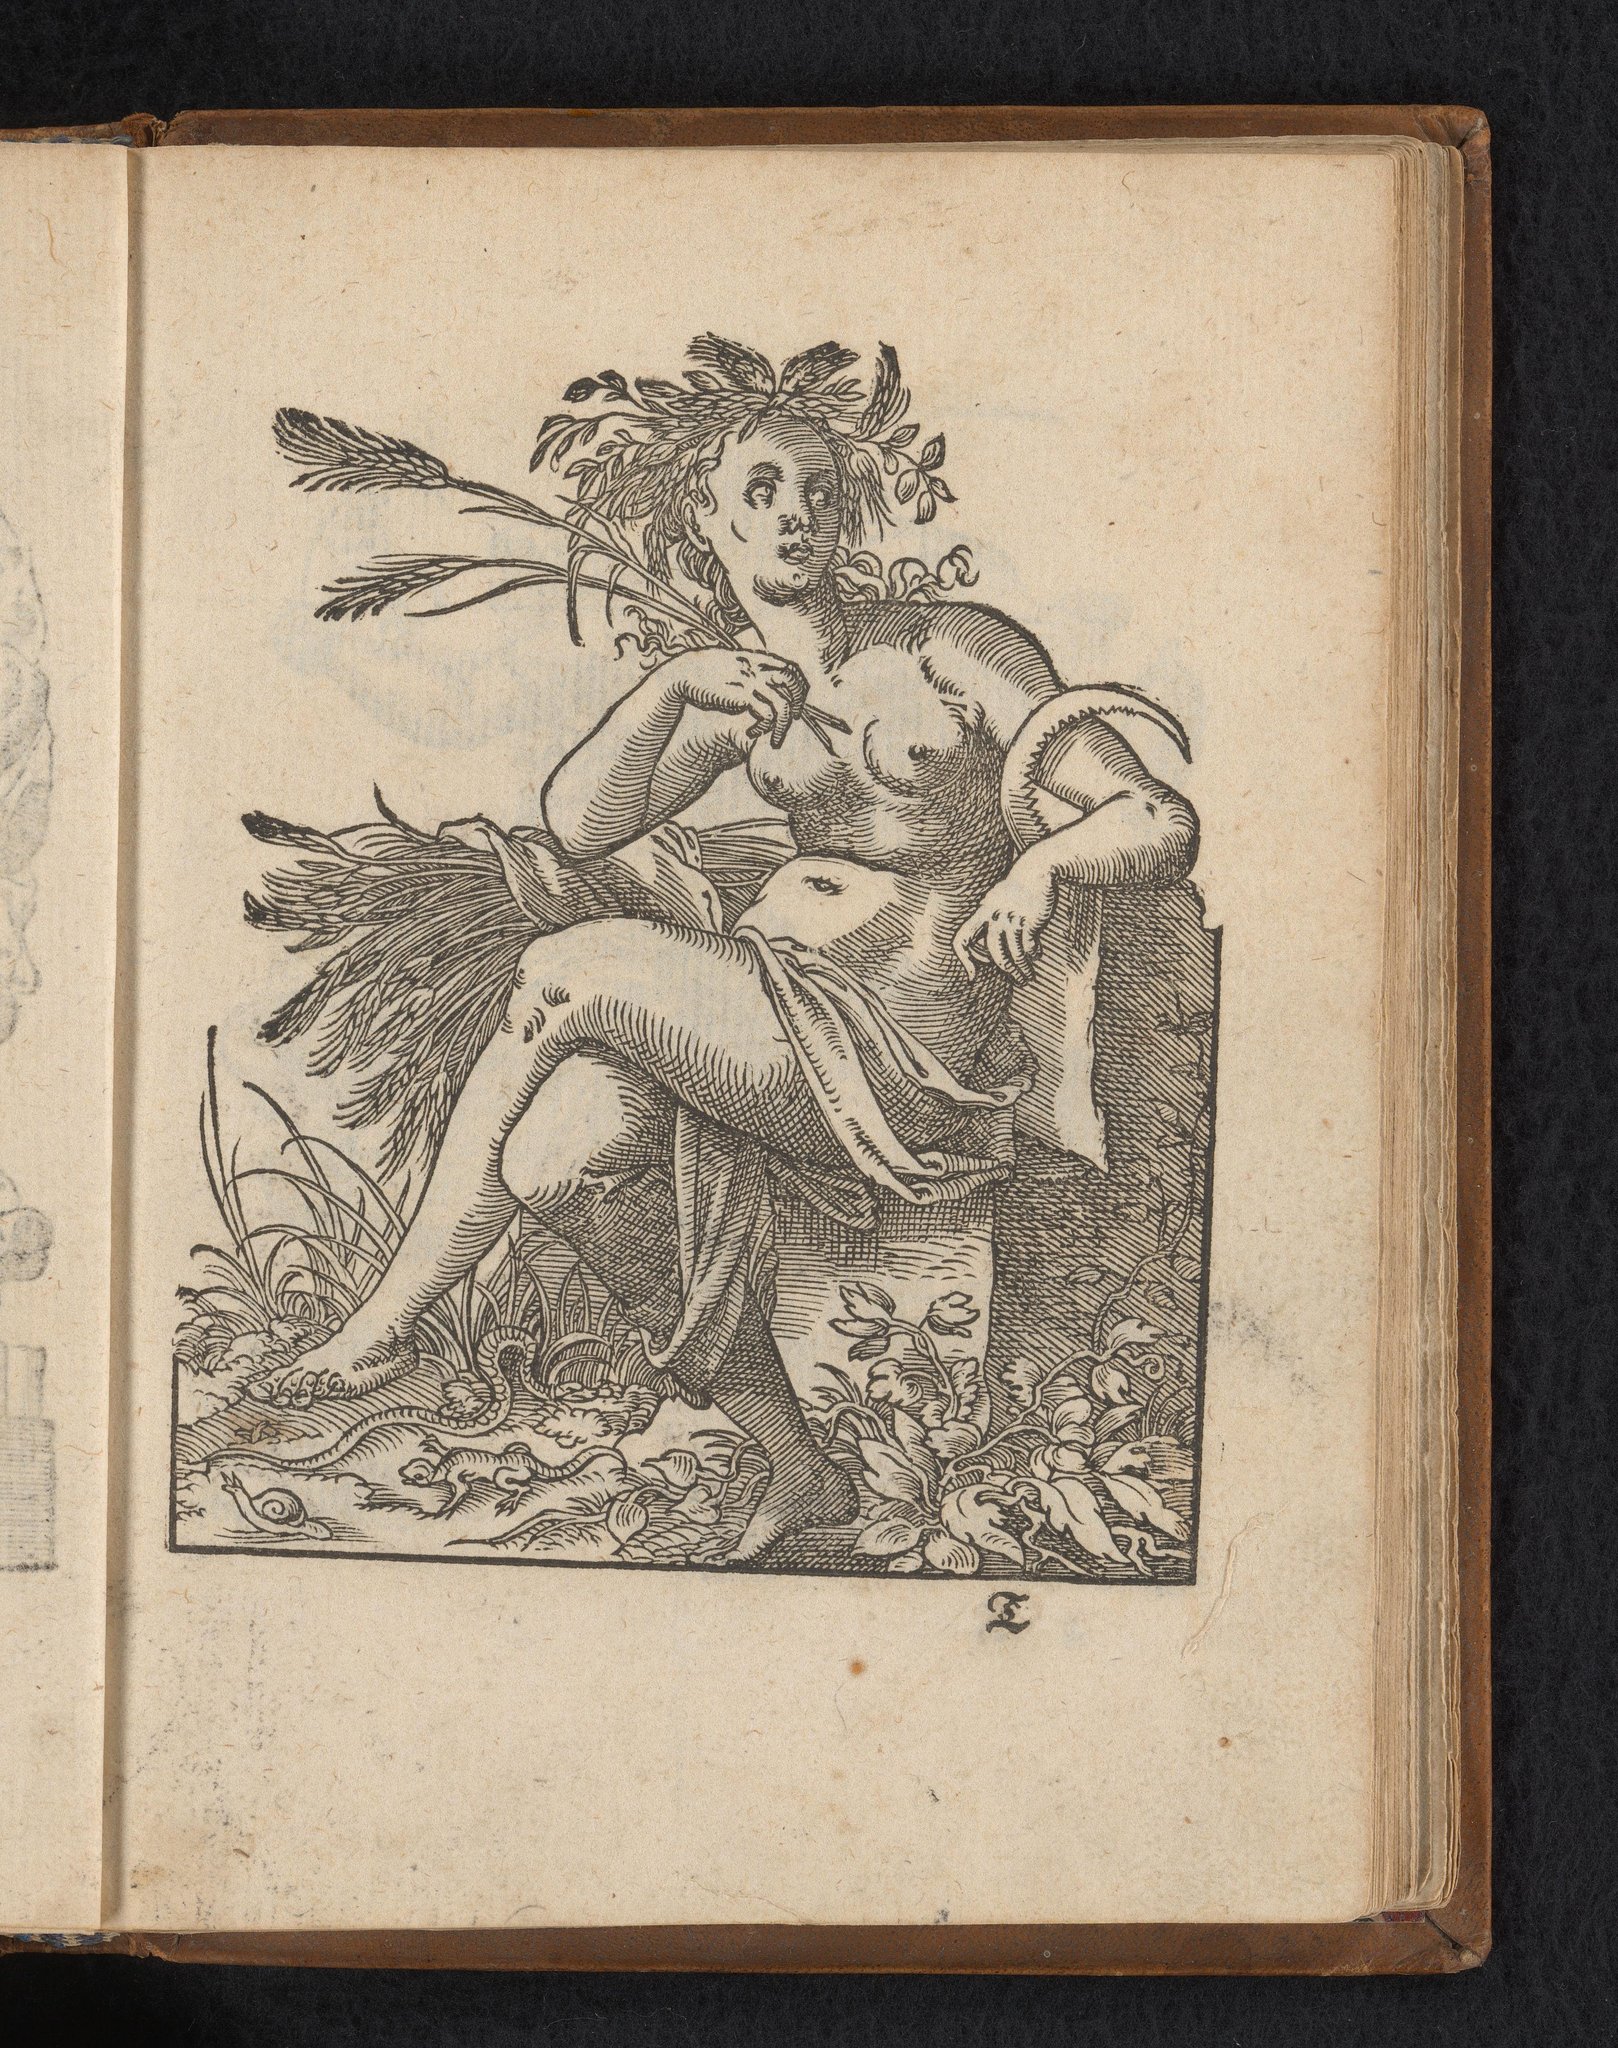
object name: print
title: Ceres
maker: Anonymous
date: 1578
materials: paper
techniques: woodcut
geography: nuremberg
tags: ceres, patroness of agriculture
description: Ceres met een kroon van bladeren, sikkel en aren in de hand, bij haar voeten kruipen dieren. Onderdeel van het modelboek Enchiridion artis pingendi, fingendi & sculpendi met 108 figuren bedoeld voor beginnende schilders, beeldhouwers en prentmakers.